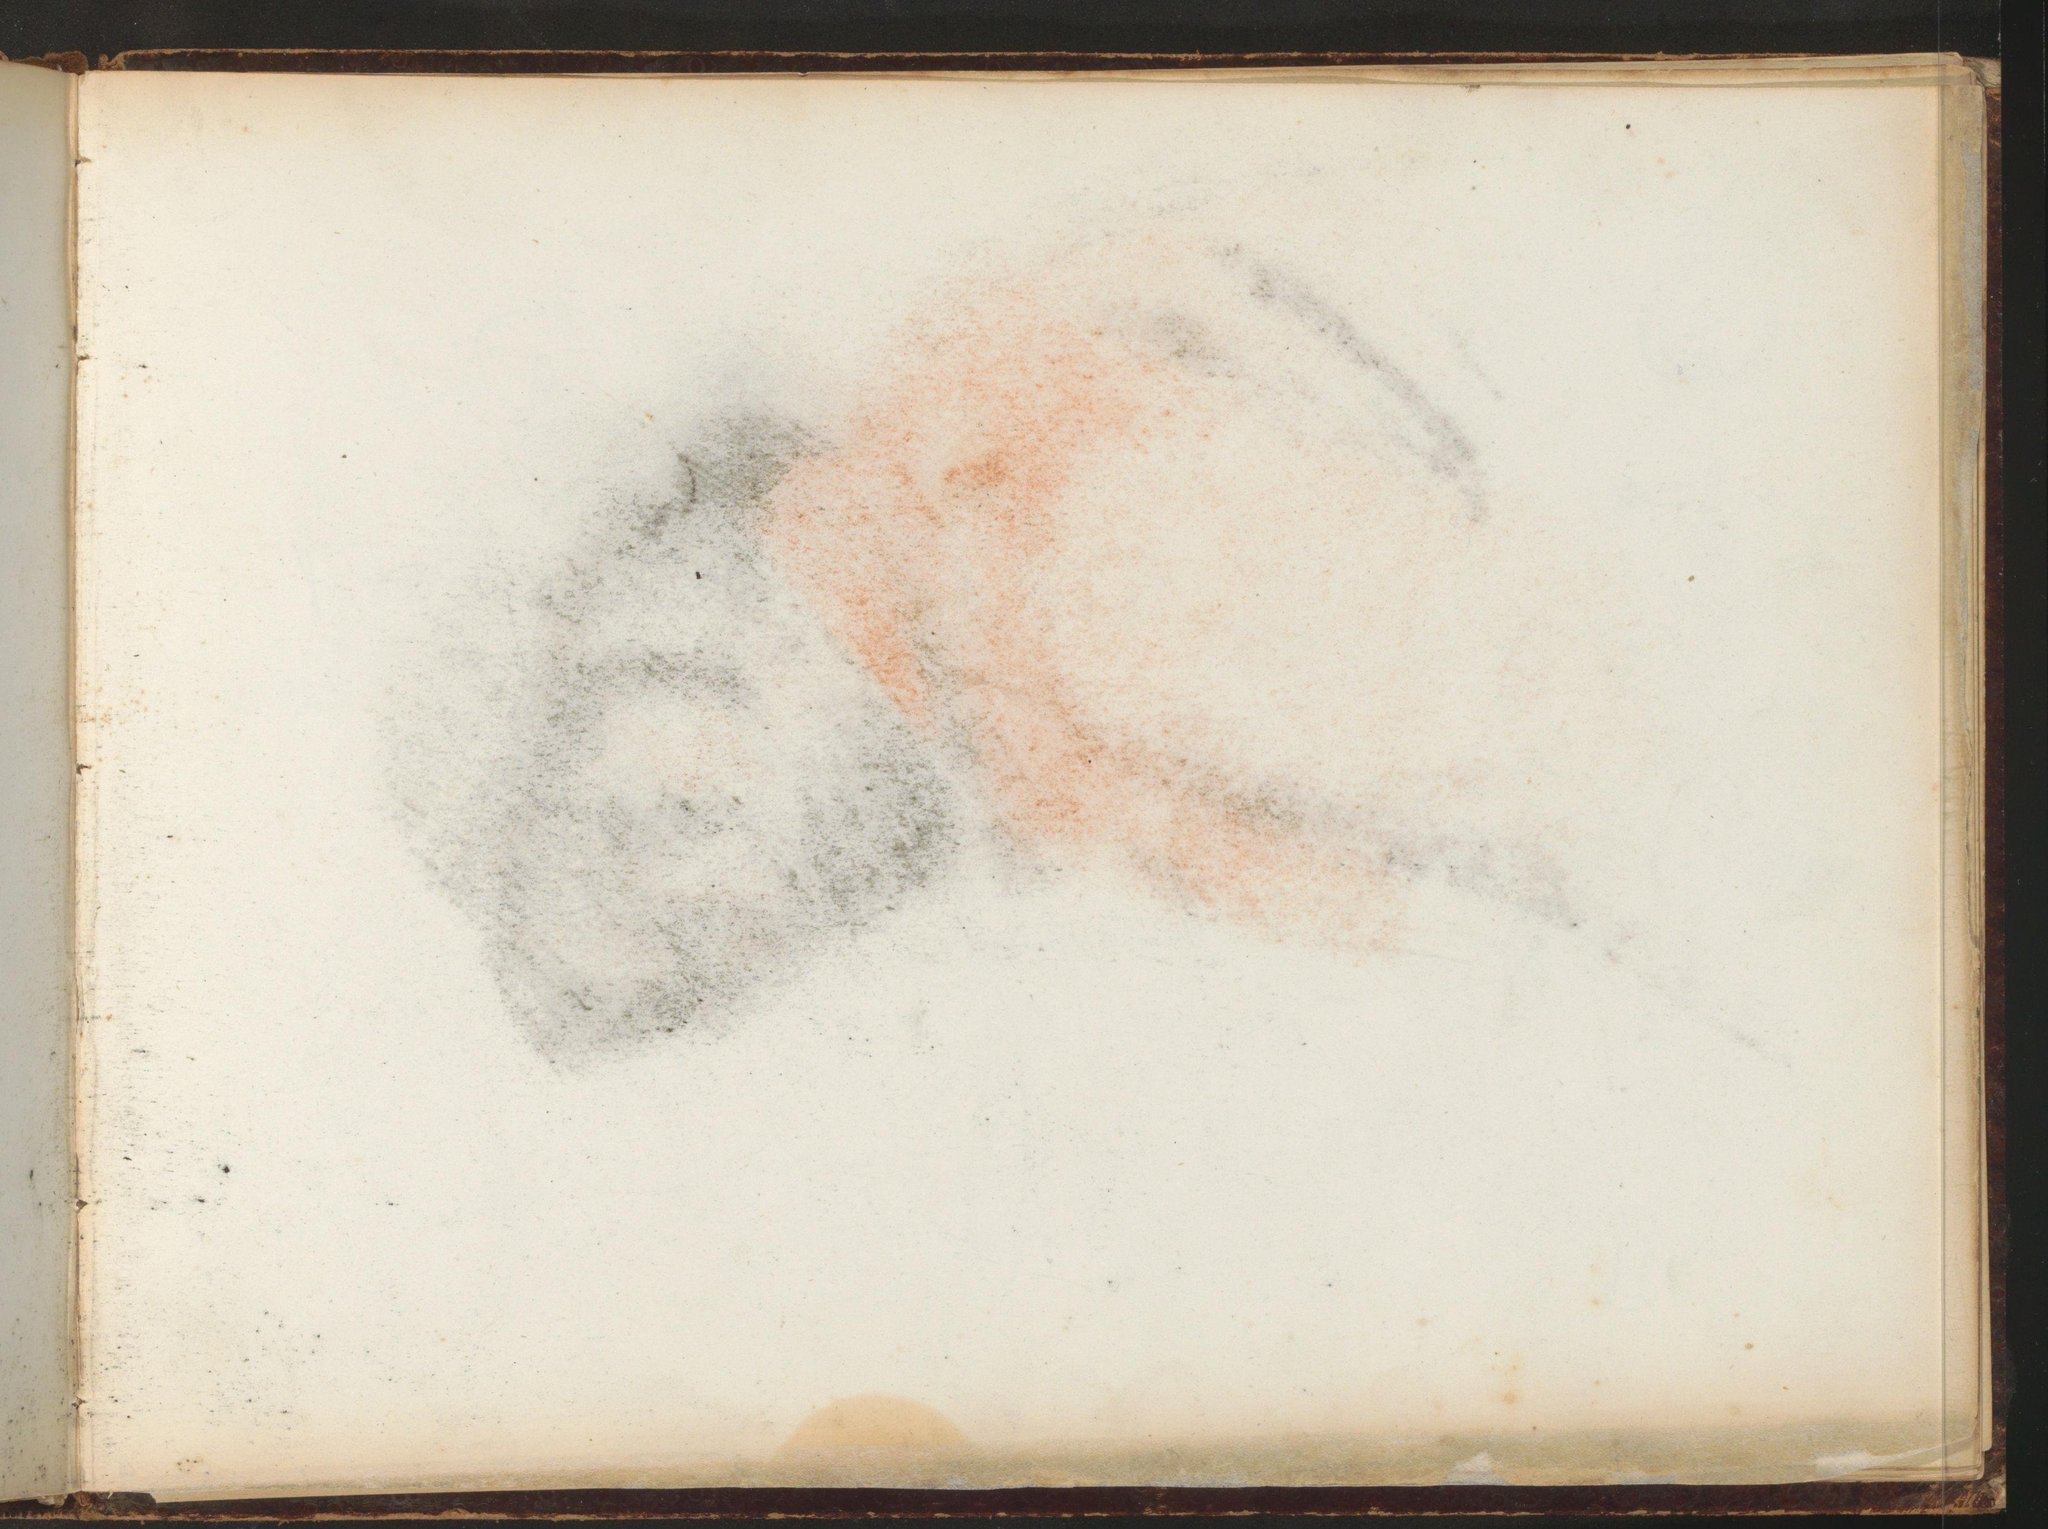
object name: sketchbook leaf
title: Abklatsch van de krijttekening op blad 36 verso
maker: reinier craeyvanger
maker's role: draughtsman, print maker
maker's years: 1812-1880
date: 1822-1880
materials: paper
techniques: printmaking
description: Blad 37 recto uit een schetsboek met 45 bladen.